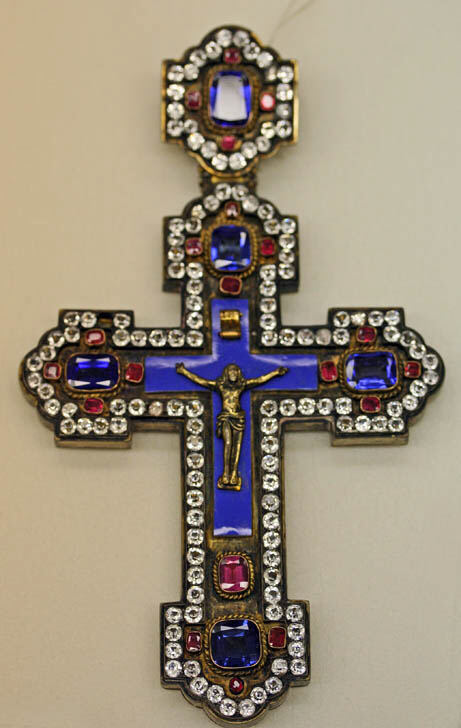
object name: pendant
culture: russian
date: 1867-1900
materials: metal, stone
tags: cross,crucifixion